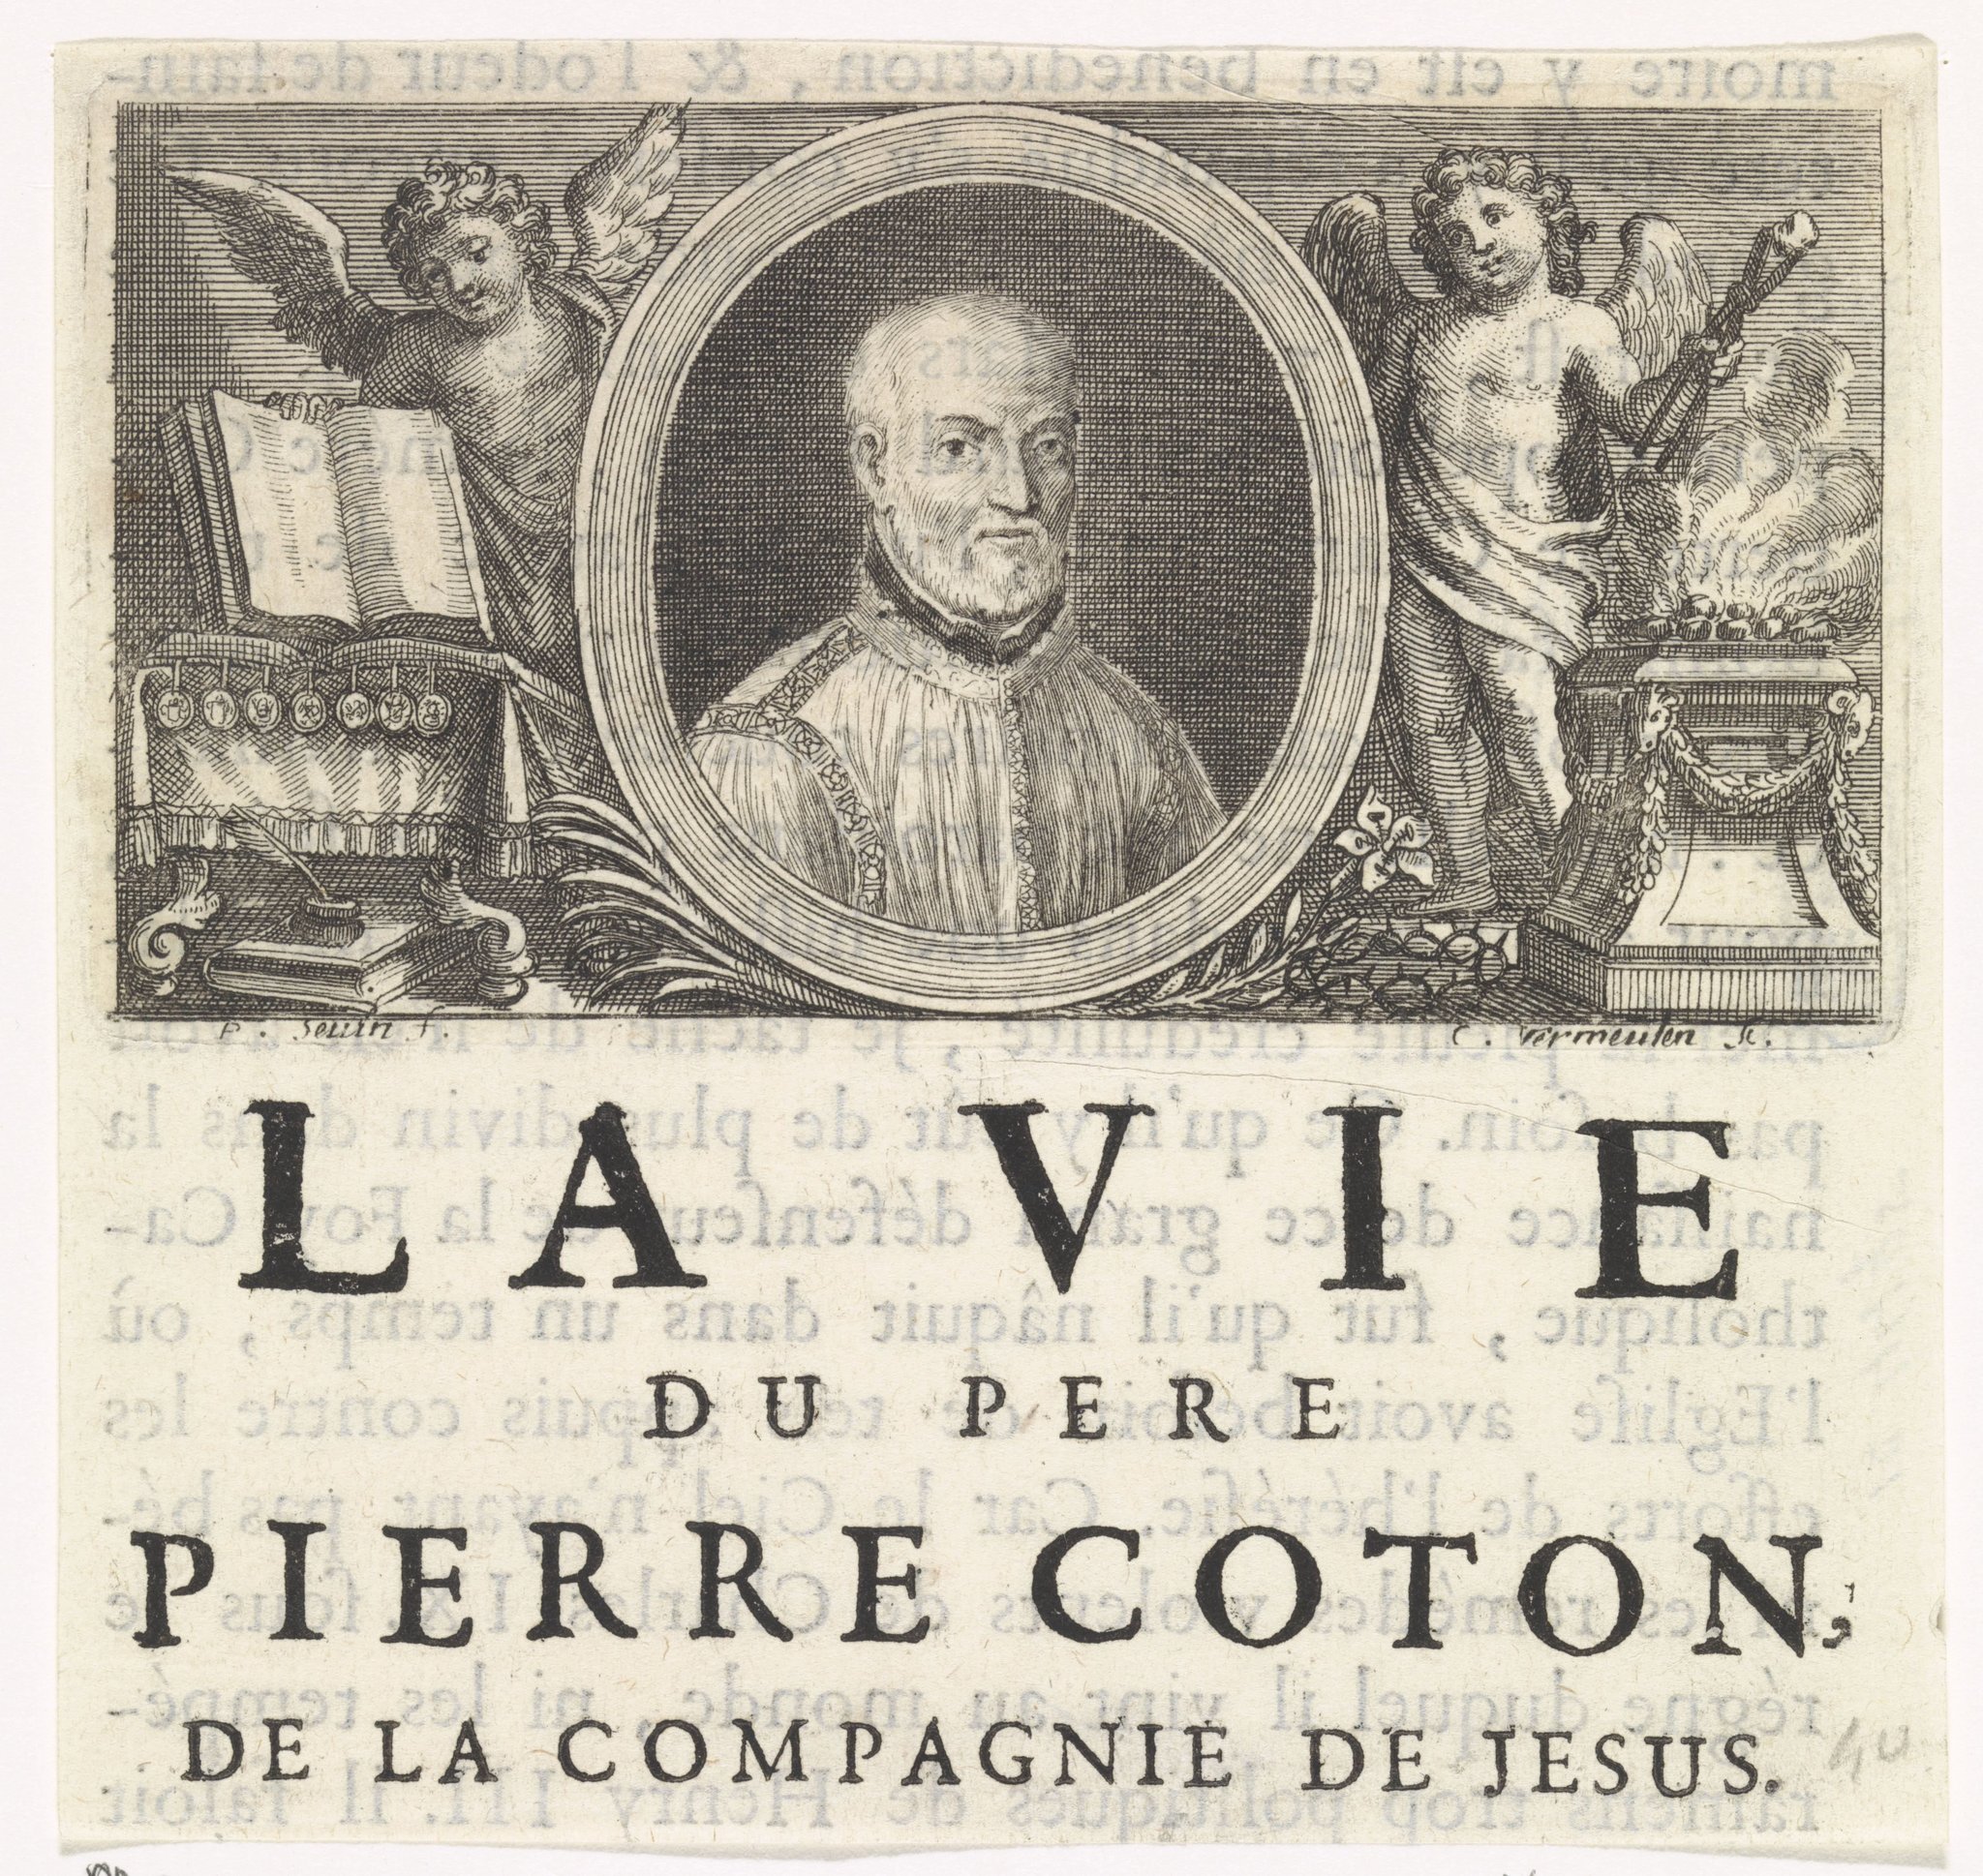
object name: book illustration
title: Portret van Pierre Coton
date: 1688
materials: paper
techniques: etching, letterpress printing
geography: paris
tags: tools, aids, implements ~ crafts and industries: tongs, the book with the seven seals enthroned ~ revelation of john, cupids: 'amores', 'amoretti', 'putti'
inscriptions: collector's mark: Lugt 2228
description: Portret van de Franse jezuïet Pierre Coton, geflankeerd door twee putti. Een van hen met het boek met de zeven zegels, de ander bij een offerzuil, waaruit hij met een tang een kooltje haalt.